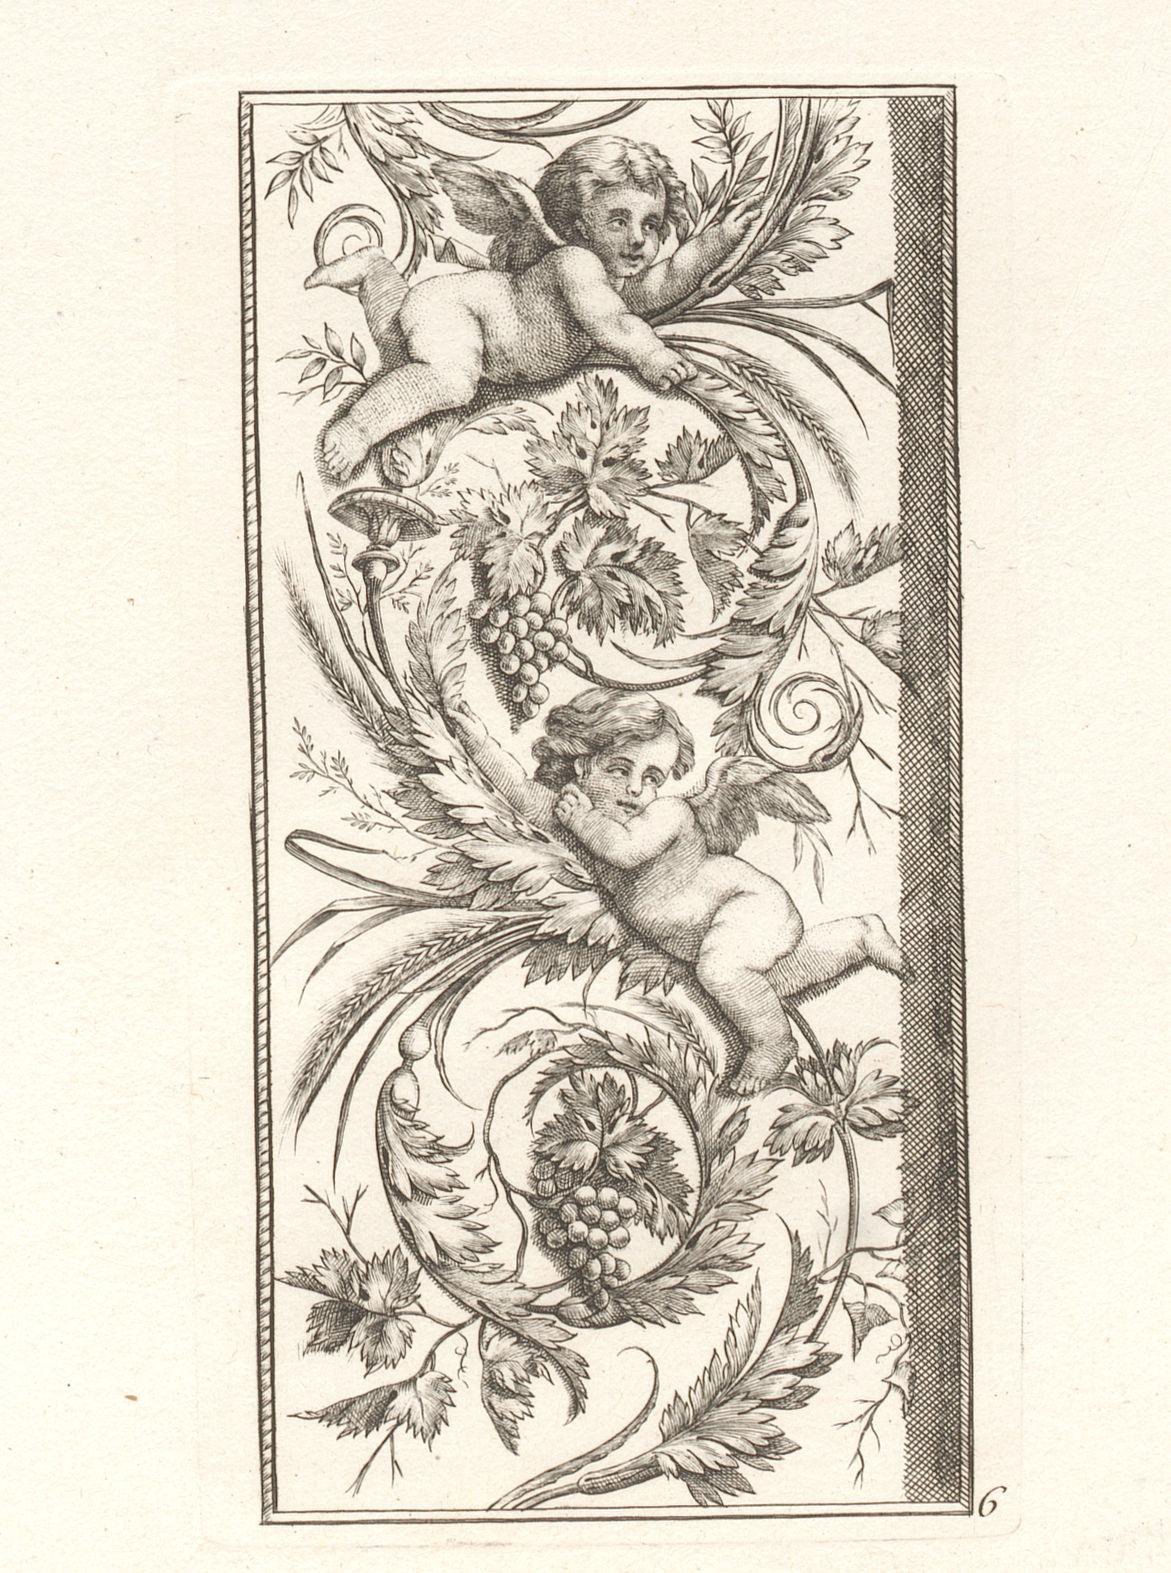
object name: album leaf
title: Recueil d'arabesques, contenant les loges du Vatican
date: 1802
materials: paper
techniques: engraving, etching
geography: paris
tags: ornament ~ arabesque, cupids: 'amores', 'amoretti', 'putti', bunch of grapes, ornament derived from plant forms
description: Doordat dit album bestaat uit meerdere, deels eerder uitgegeven prentreeksen, is de datering niet consequent. Het geheel is op de titelpagina gedateerd op 1802. Deze reeks is niet afzonderlijk gedateerd. De serietitel voor het gehele werk is "Recueil d'arabesques, contenant les loges du Vatican". De andere serietitel is de titel van de specifieke reeks binnen het geheel.